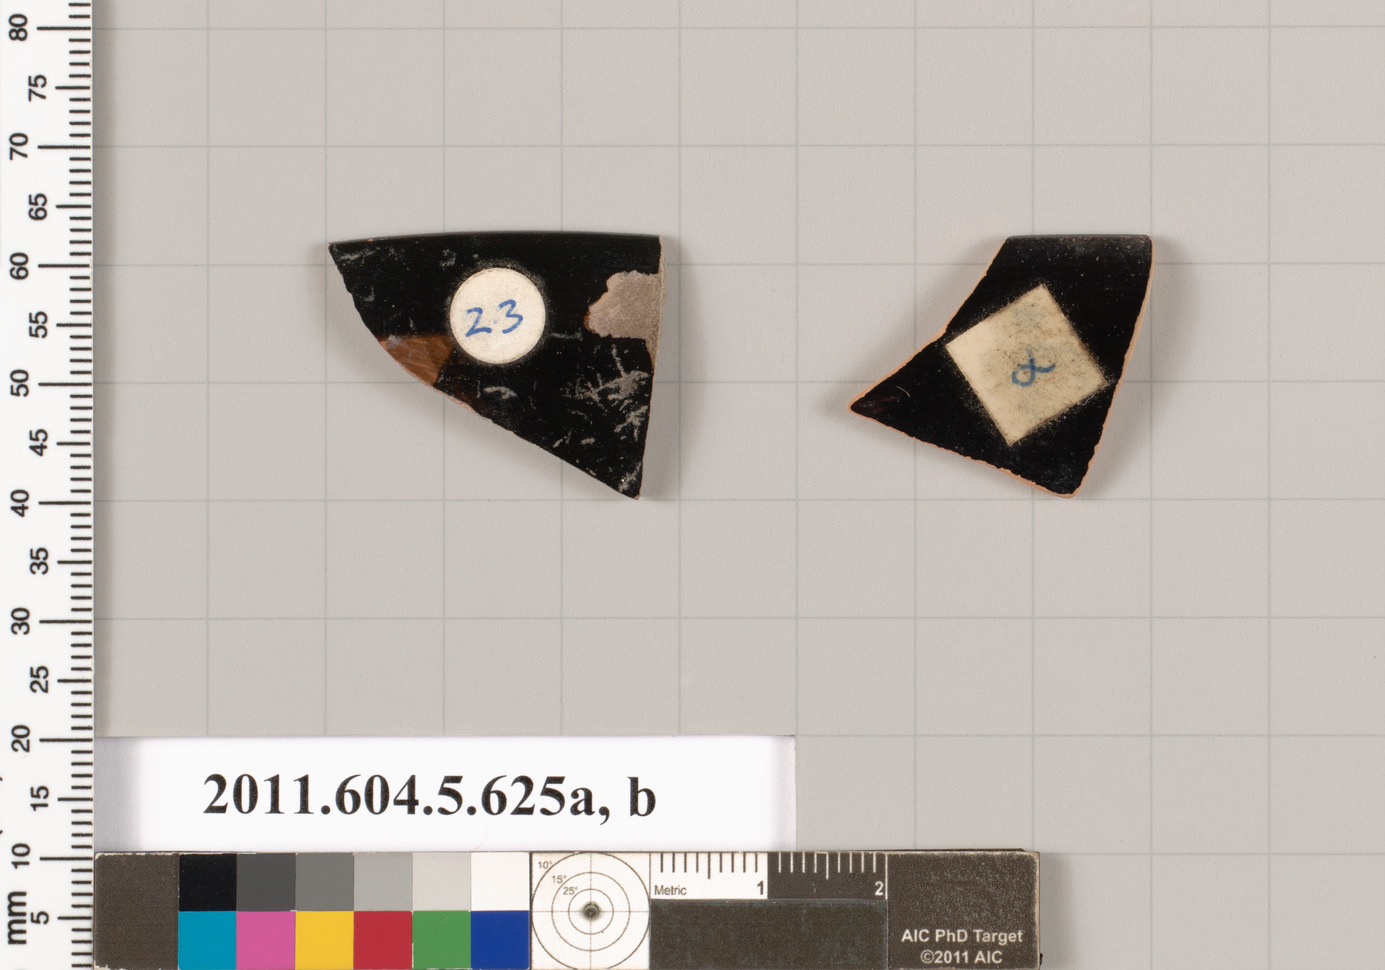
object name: kylix fragment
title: Terracotta rim fragments of kylikes (drinking cups)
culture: greek, attic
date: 600-401 BCE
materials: terracotta